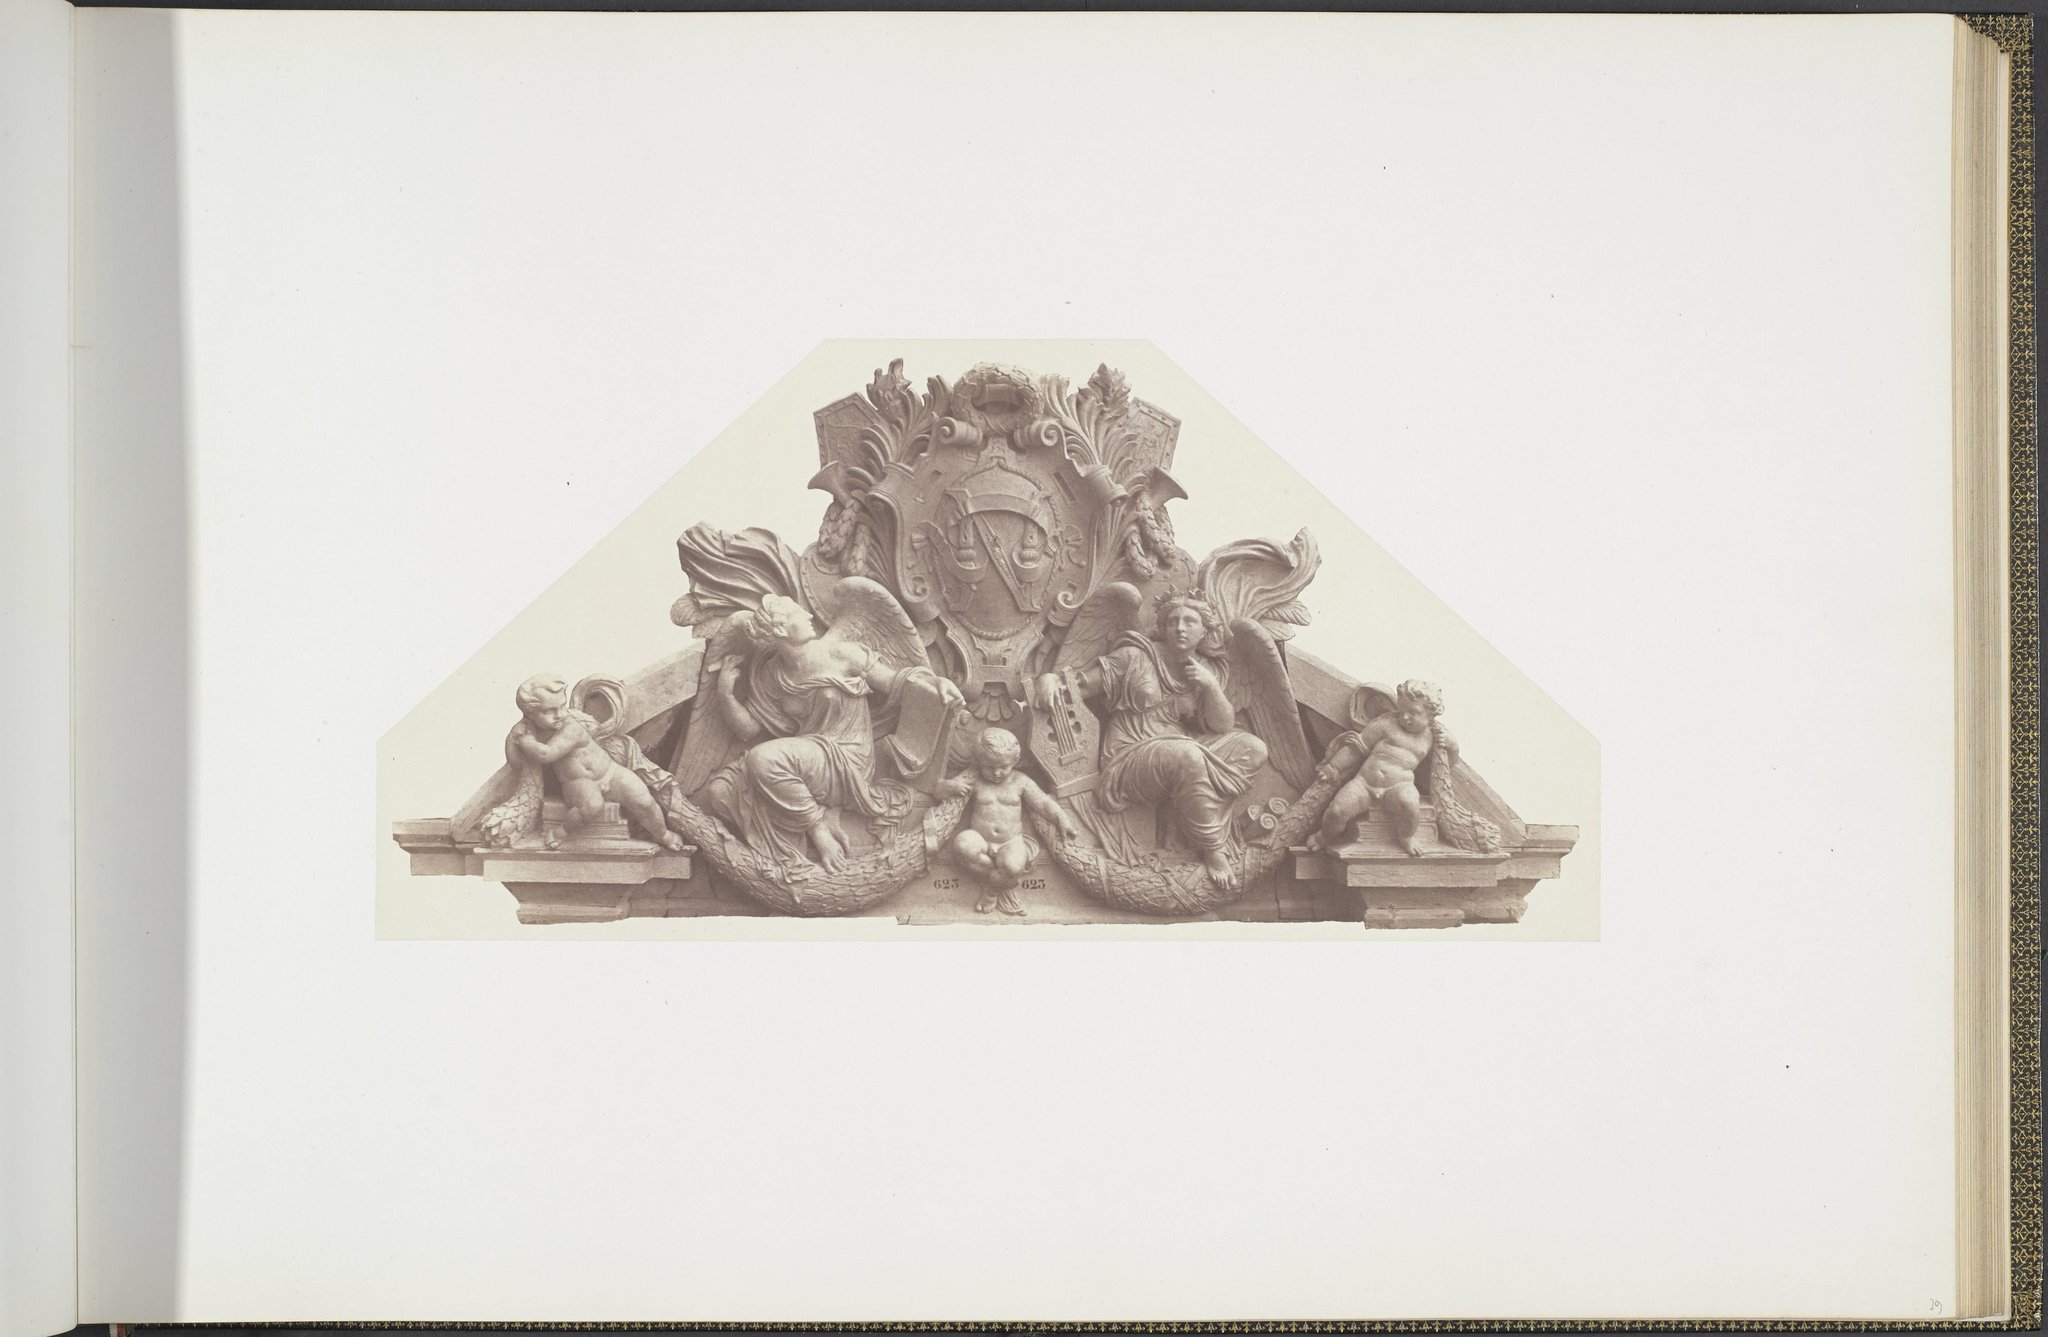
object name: album leaf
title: Gipsmodel voor beeldhouwwerk op het Palais du Louvre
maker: édouard denis baldus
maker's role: fotograaf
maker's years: 1813-1889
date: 1855-1857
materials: paper, photographic support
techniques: salted paper print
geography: paris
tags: piece of sculpture, reproduction of a piece of sculpture, permanent exhibition, museum, paris, tuileries palace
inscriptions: number: ‘623’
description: Onderdeel van Réunion des Tuileries au Louvre 1852-1857, album 1.